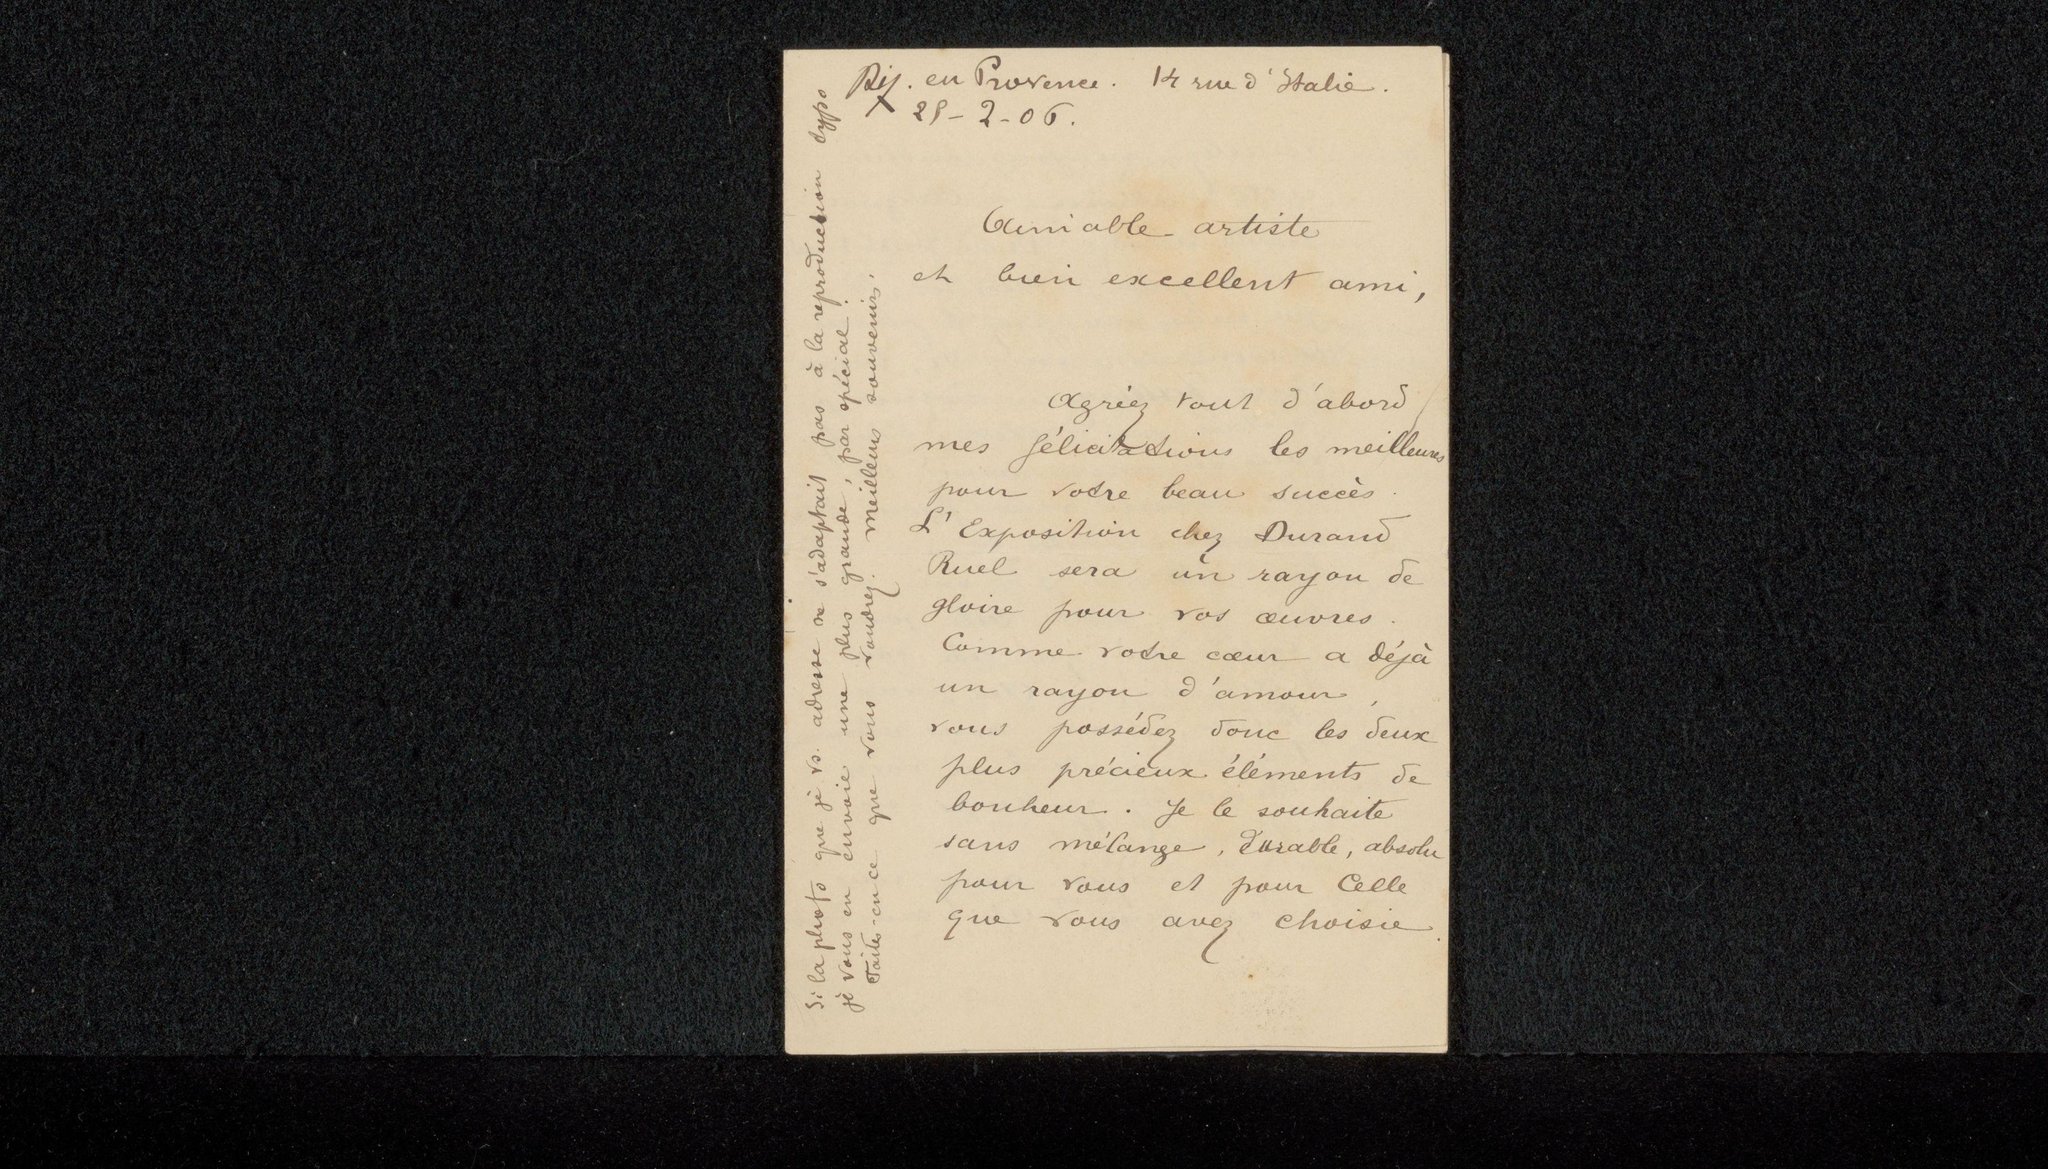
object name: letter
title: Brief aan Philip Zilcken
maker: eugénie clapier-houchart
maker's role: dichter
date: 1906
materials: ink, paper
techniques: pen, writing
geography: aix-en-provence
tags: painter, draughtsman, philip zilcken, literature ~ arts, photography, cinematography, temporary exhibition, 'salon'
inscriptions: collector's mark: ‘RPK’, seal